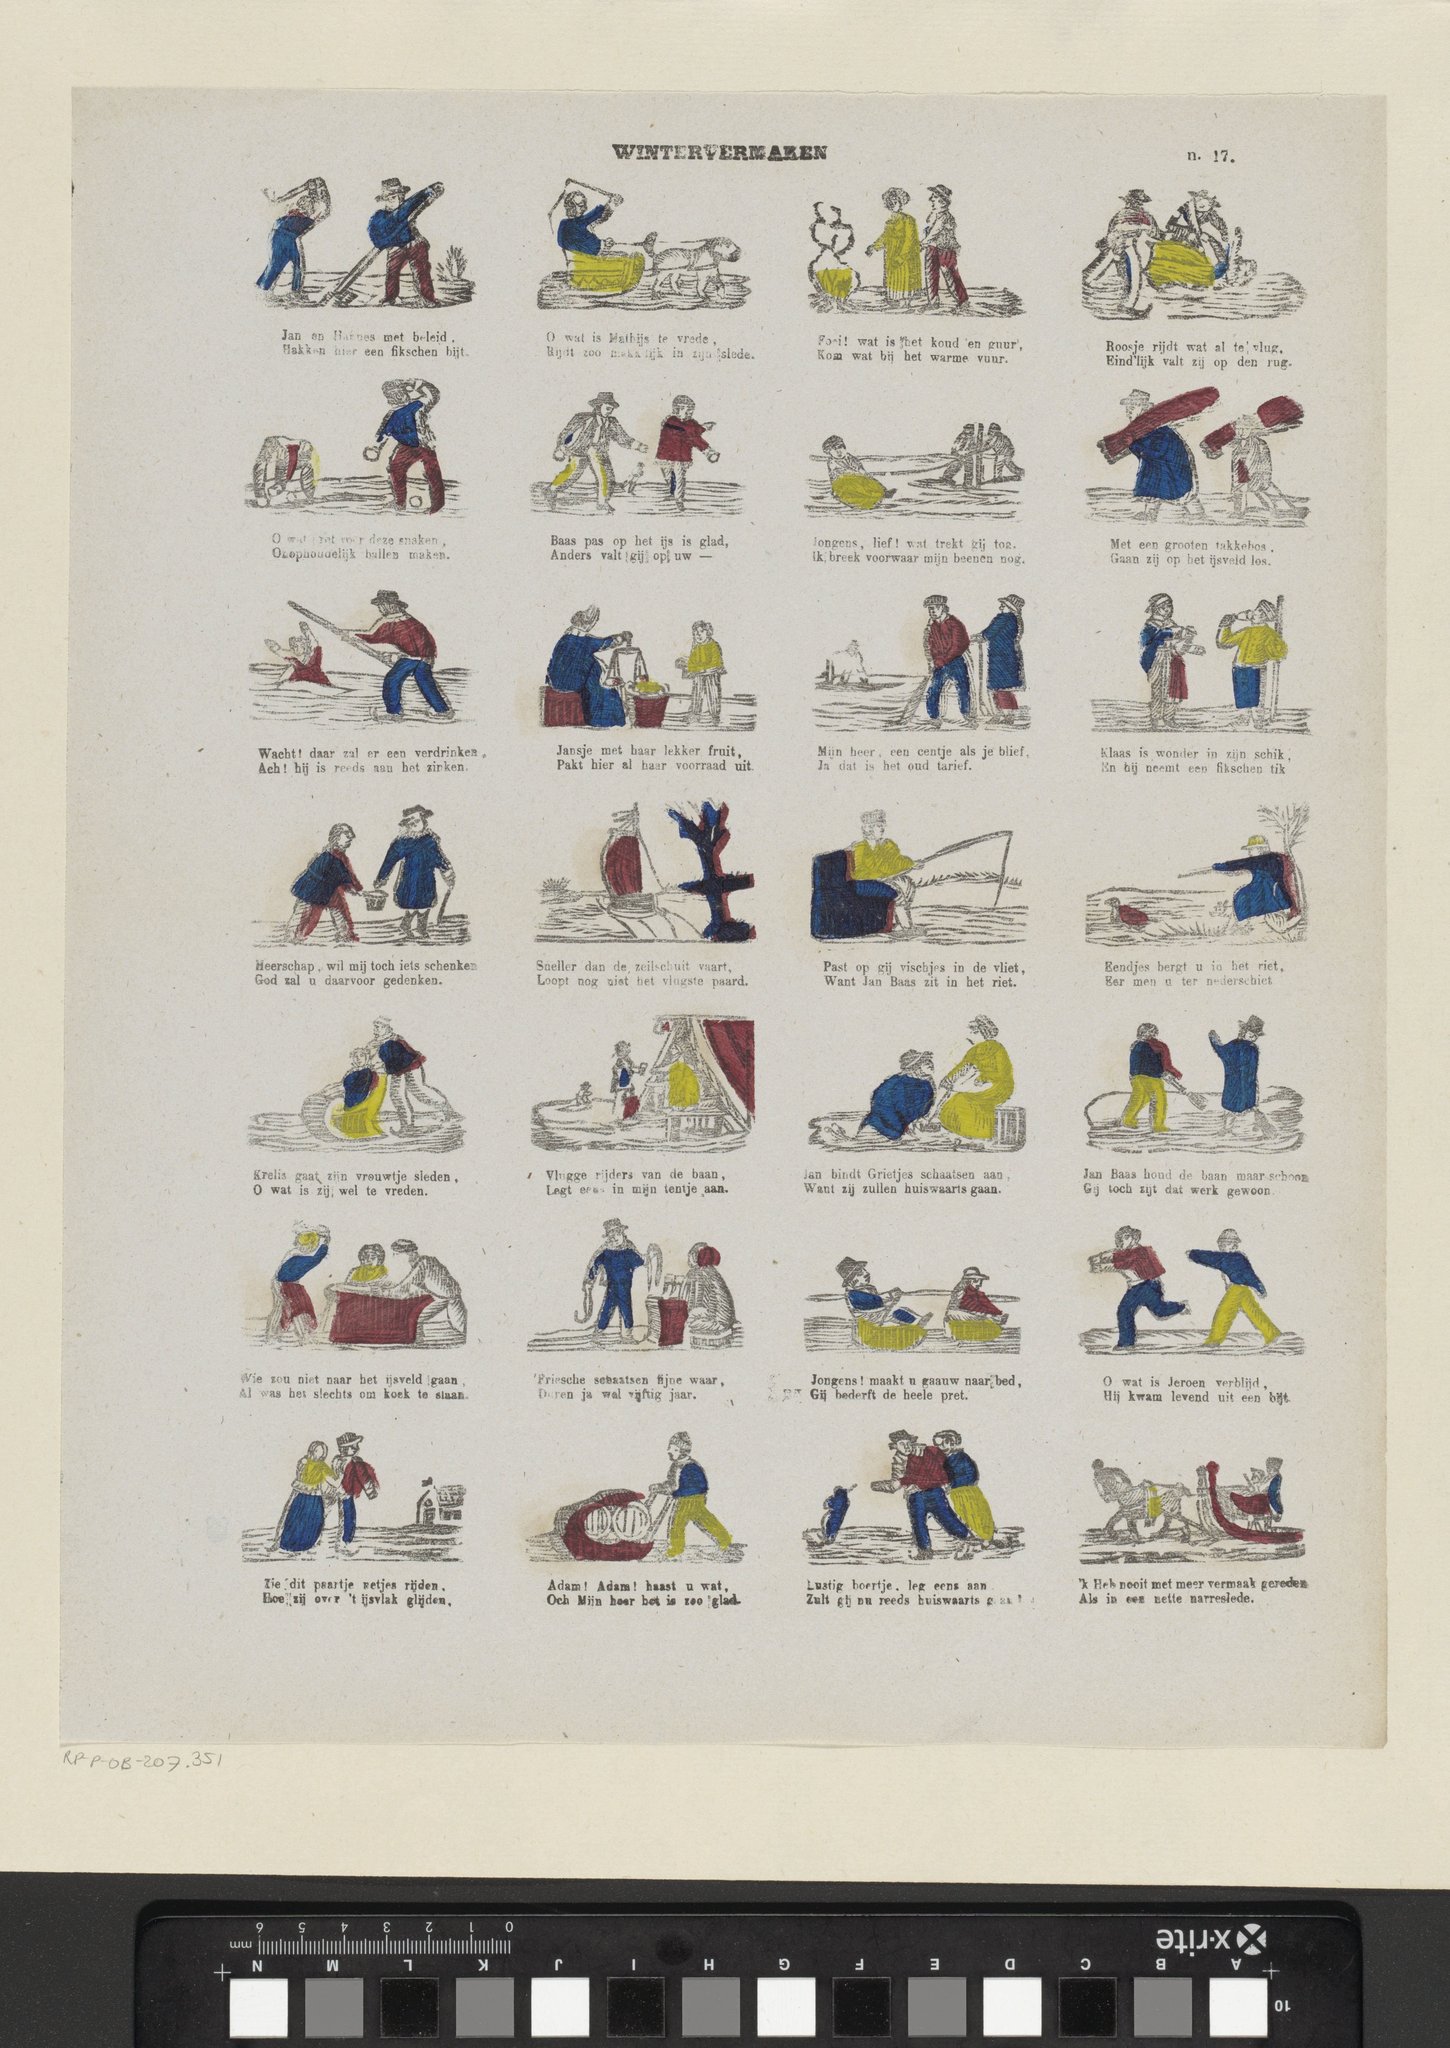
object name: popular print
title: Wintervermaken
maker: Anonymous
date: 1848-1881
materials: paper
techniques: colour, letterpress printing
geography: den bosch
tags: winter sports, skates (winter sports), sledge, sleigh (winter sports)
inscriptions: collector's mark: Lugt 2760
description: Blad met 28 voorstellingen van winterse activiteiten, zoals schaatsen en sleeën. Onder elke afbeelding een tweeregelig vers. Genummerd rechtsboven: n. 17.